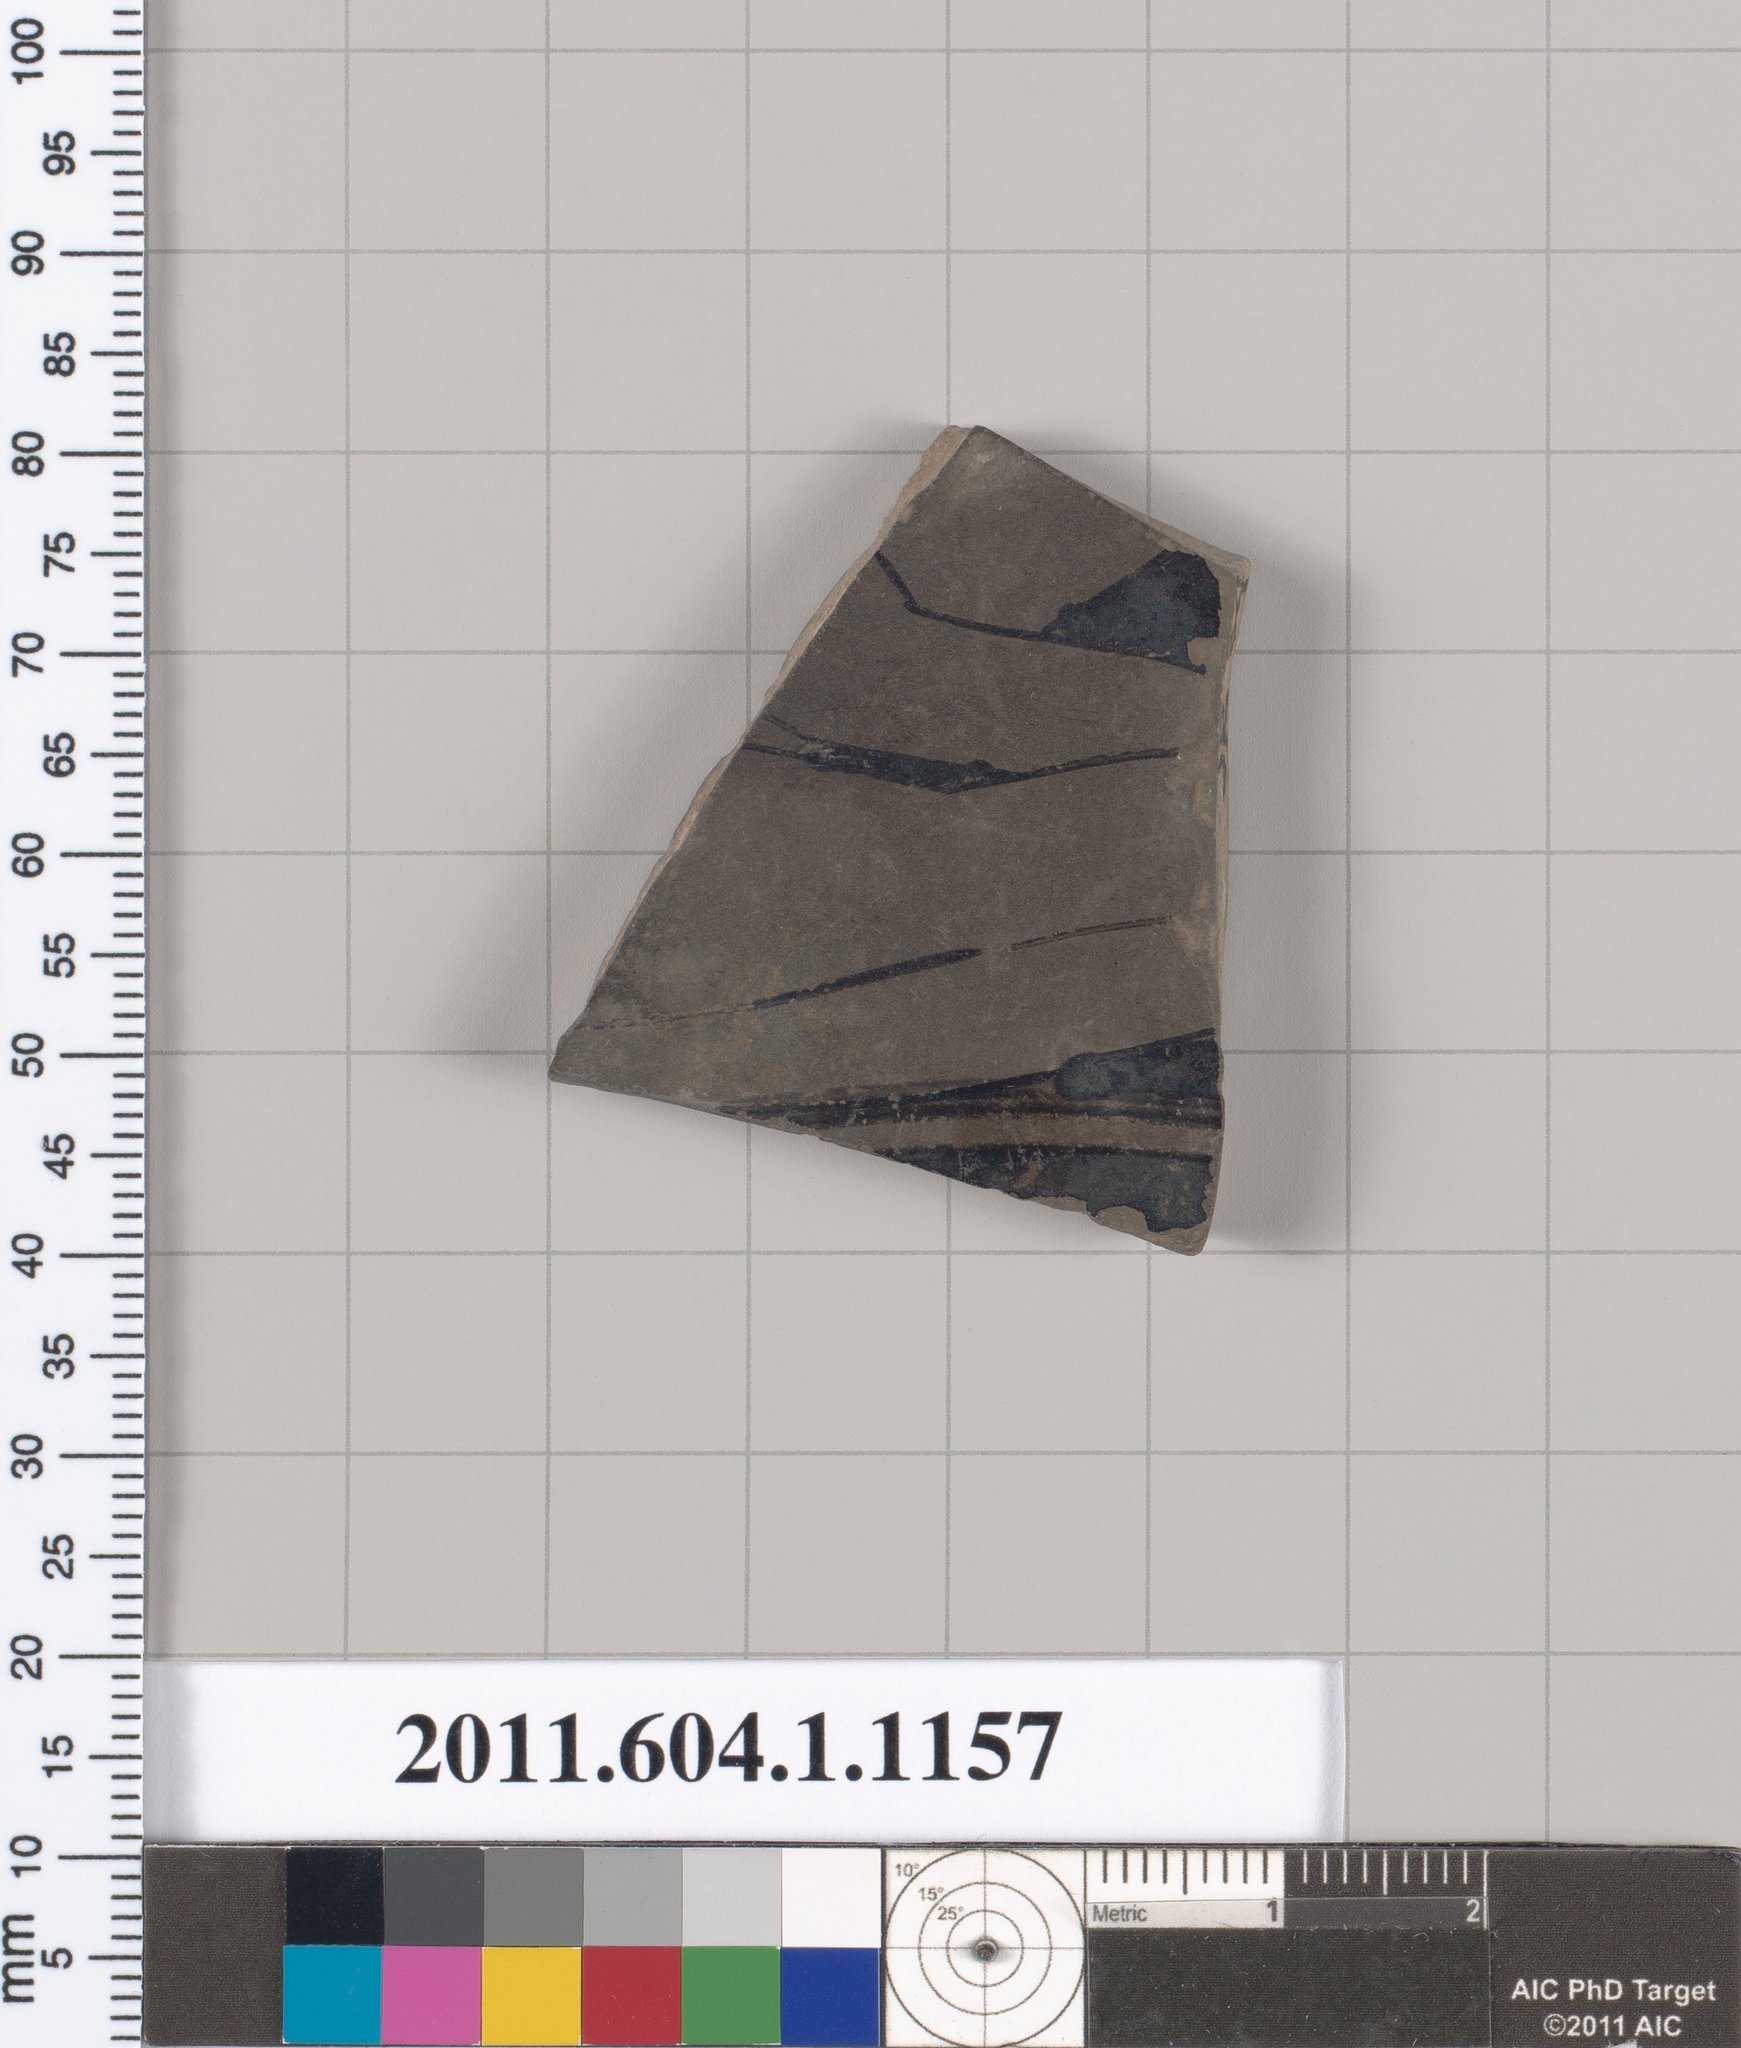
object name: kylix fragment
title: Terracotta fragment of a kylix (drinking cup)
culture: greek, attic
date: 475-451 BCE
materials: terracotta